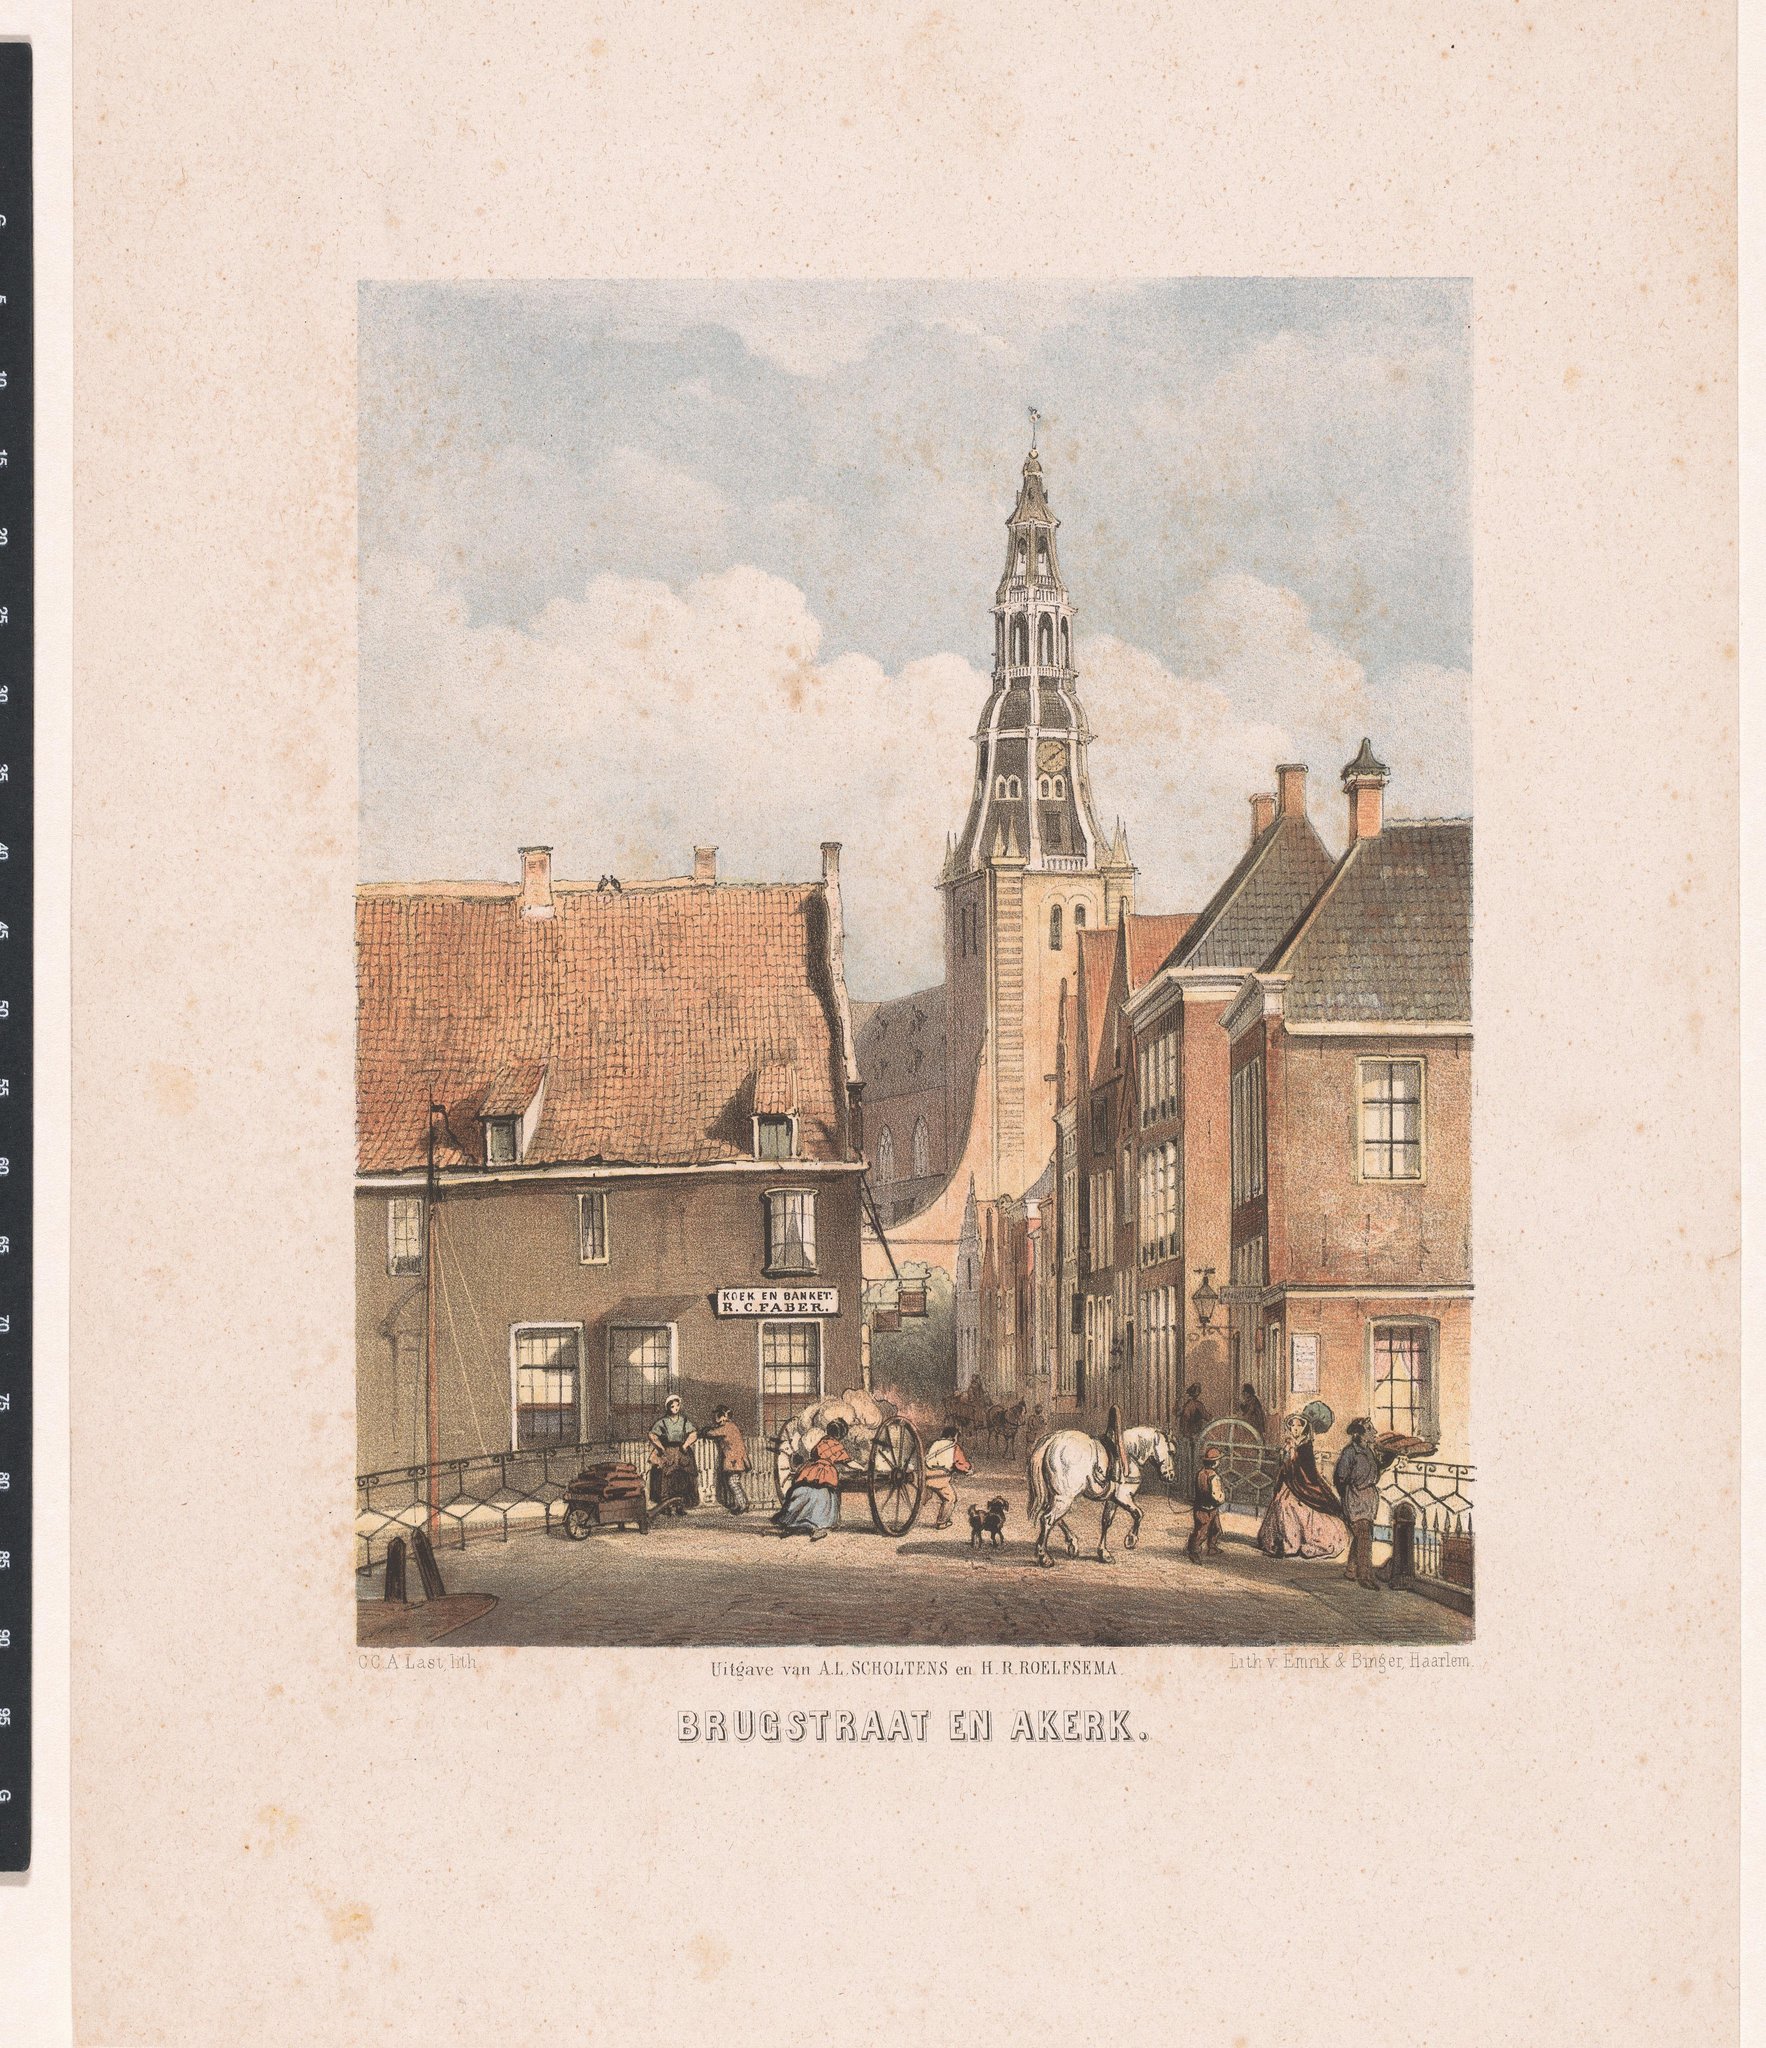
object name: print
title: Brugstraat en Akerk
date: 1857-1869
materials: paper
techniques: lithograph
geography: groningen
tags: street (+ city(-scape) with figures, staffage), parts of church exterior and annexes: tower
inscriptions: collector's mark: Lugt 2228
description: Behoort tot een serie van, in ieder geval, twaalf prenten over Groningen. Zie RP-P-1905-63 t/m RP-P-1905-74.